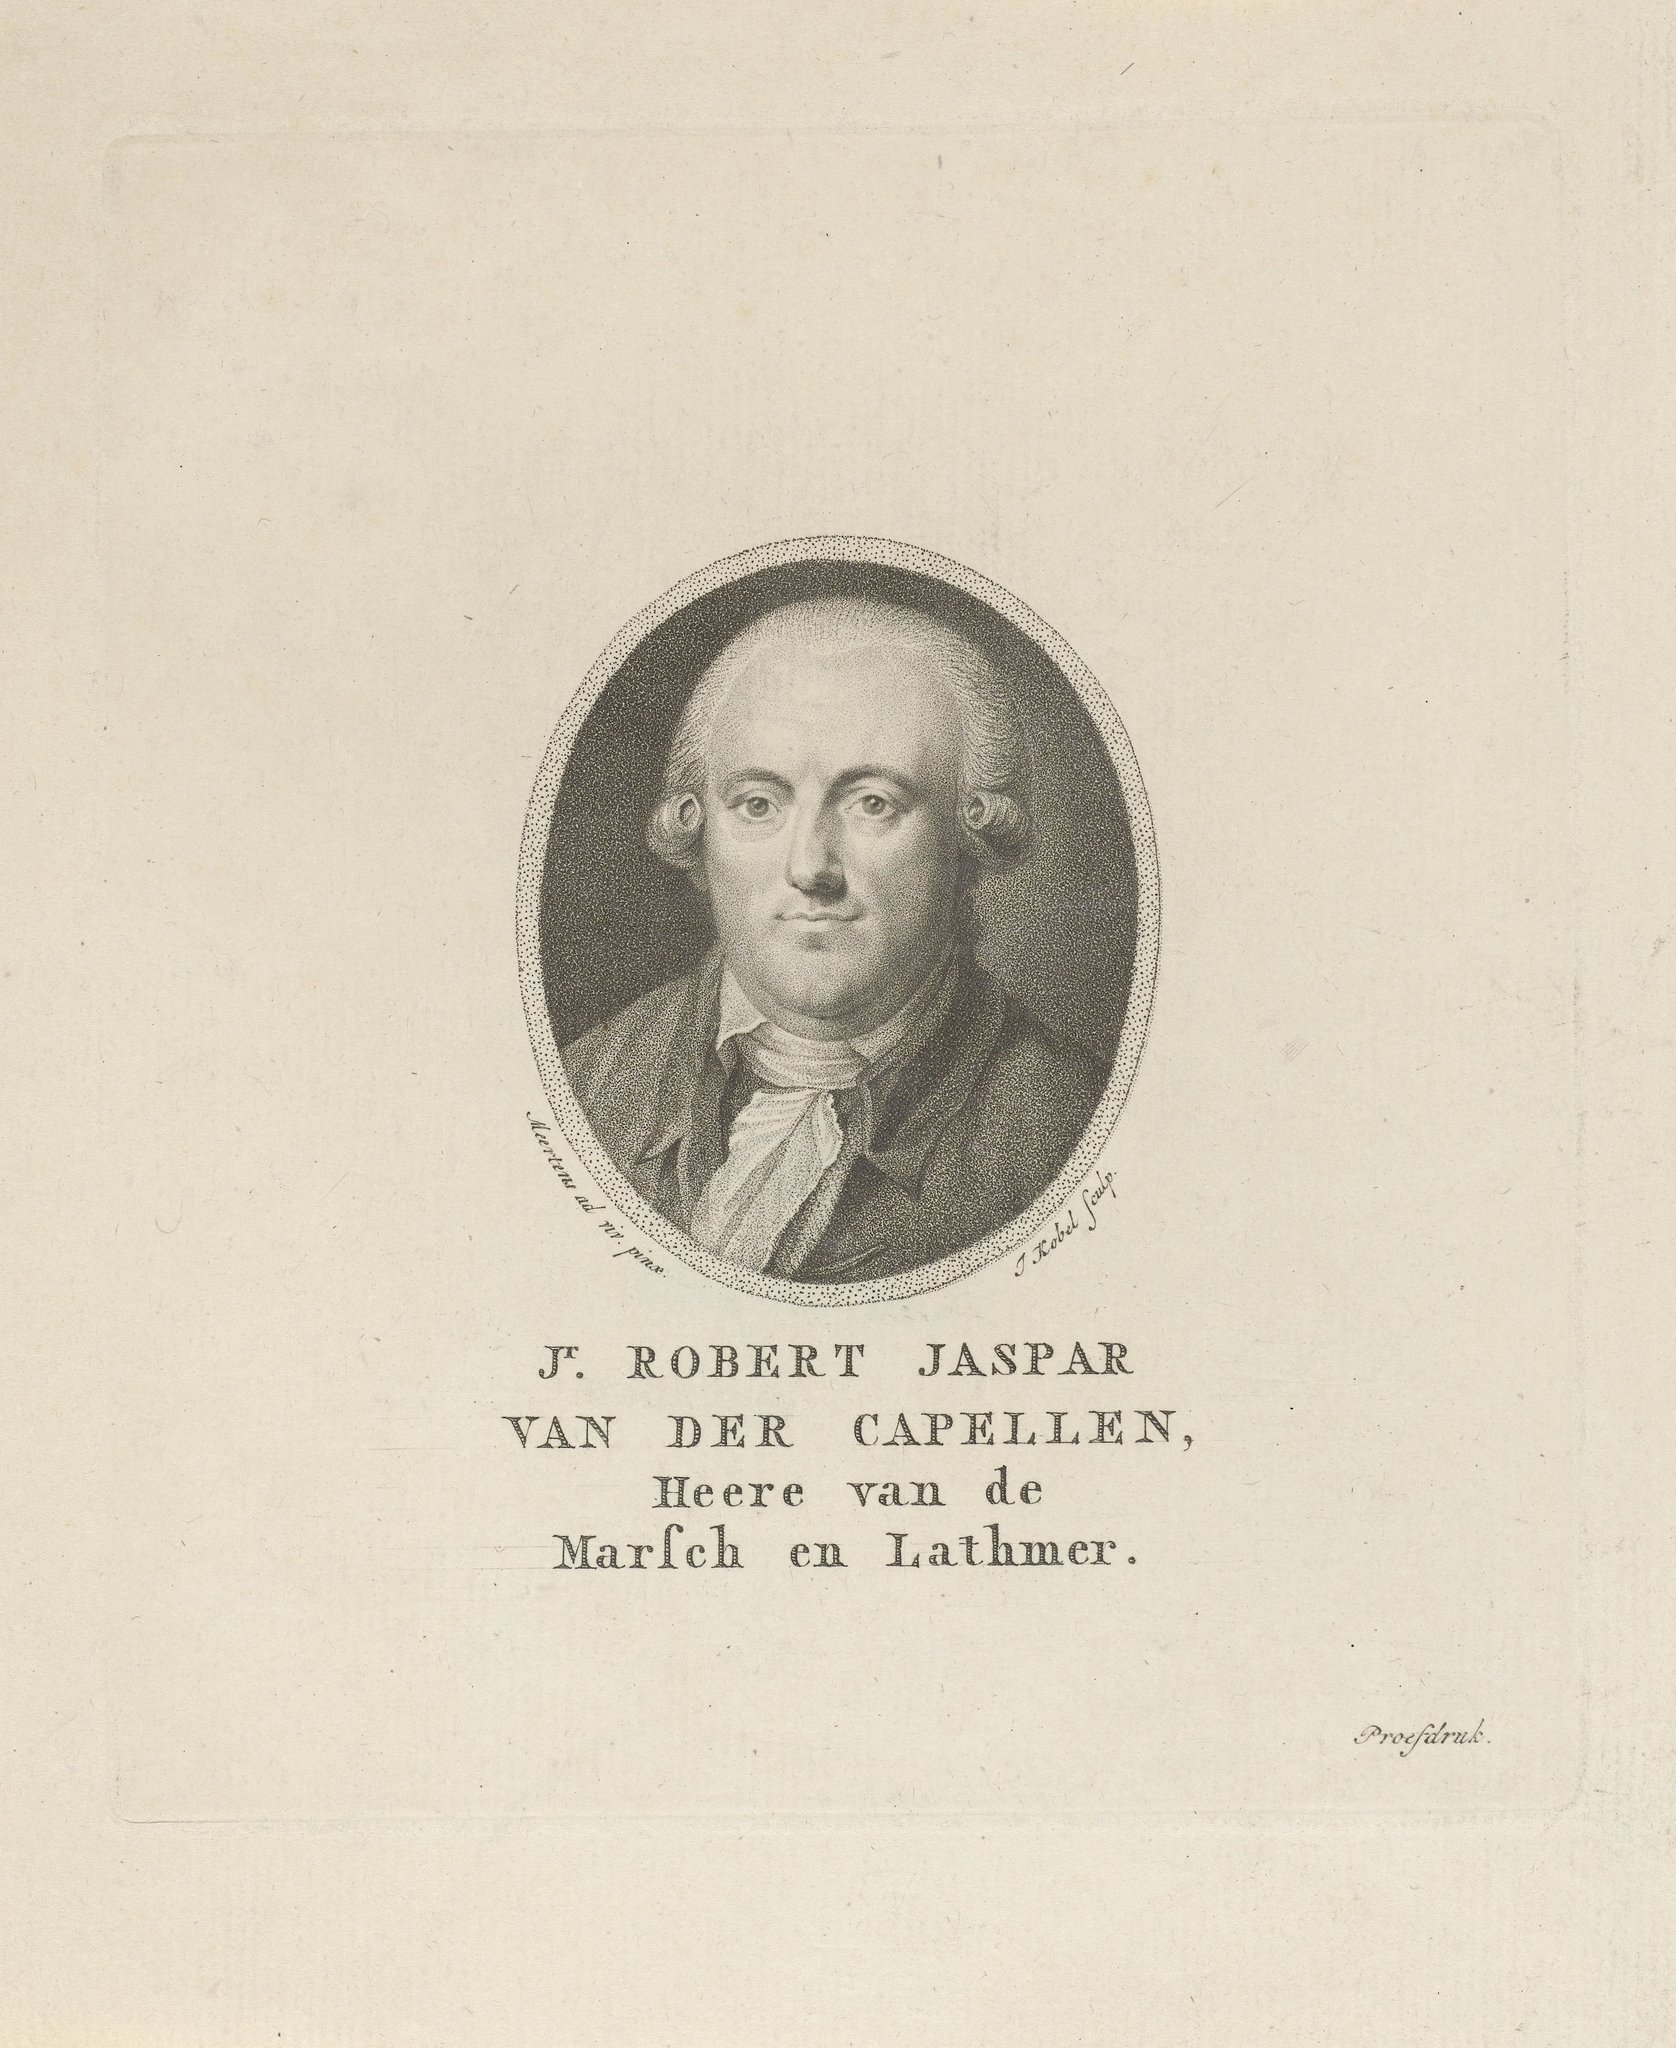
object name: print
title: Portret van Robert Jasper van der Capellen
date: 1766-1833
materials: paper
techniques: etching, engraving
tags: deventer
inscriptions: collector's mark: Lugt 2228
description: Portretbuste van de patriot Robert Jasper van der Capellen.